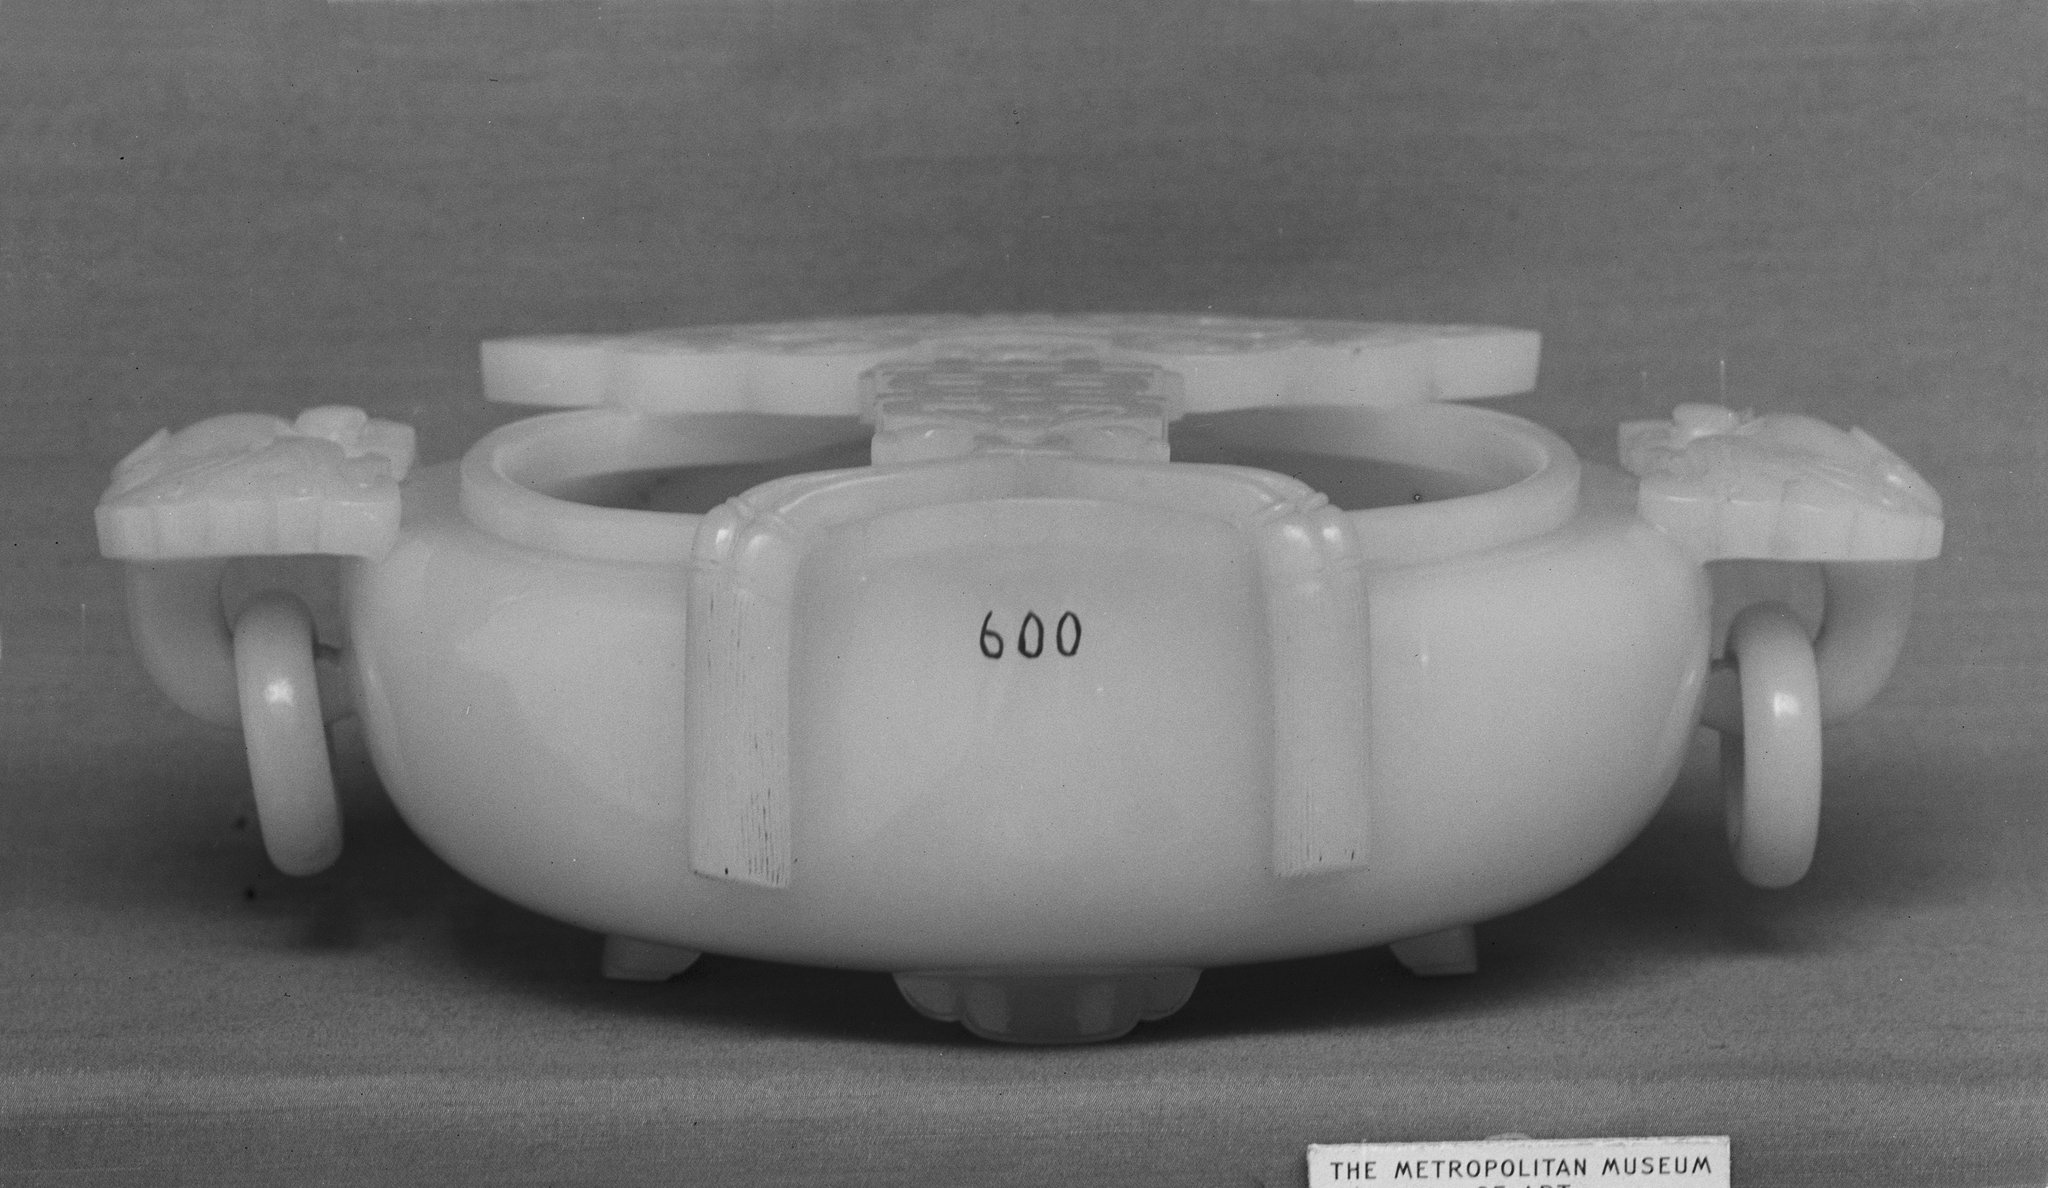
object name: marriage cup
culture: chinese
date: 1701-1900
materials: jade